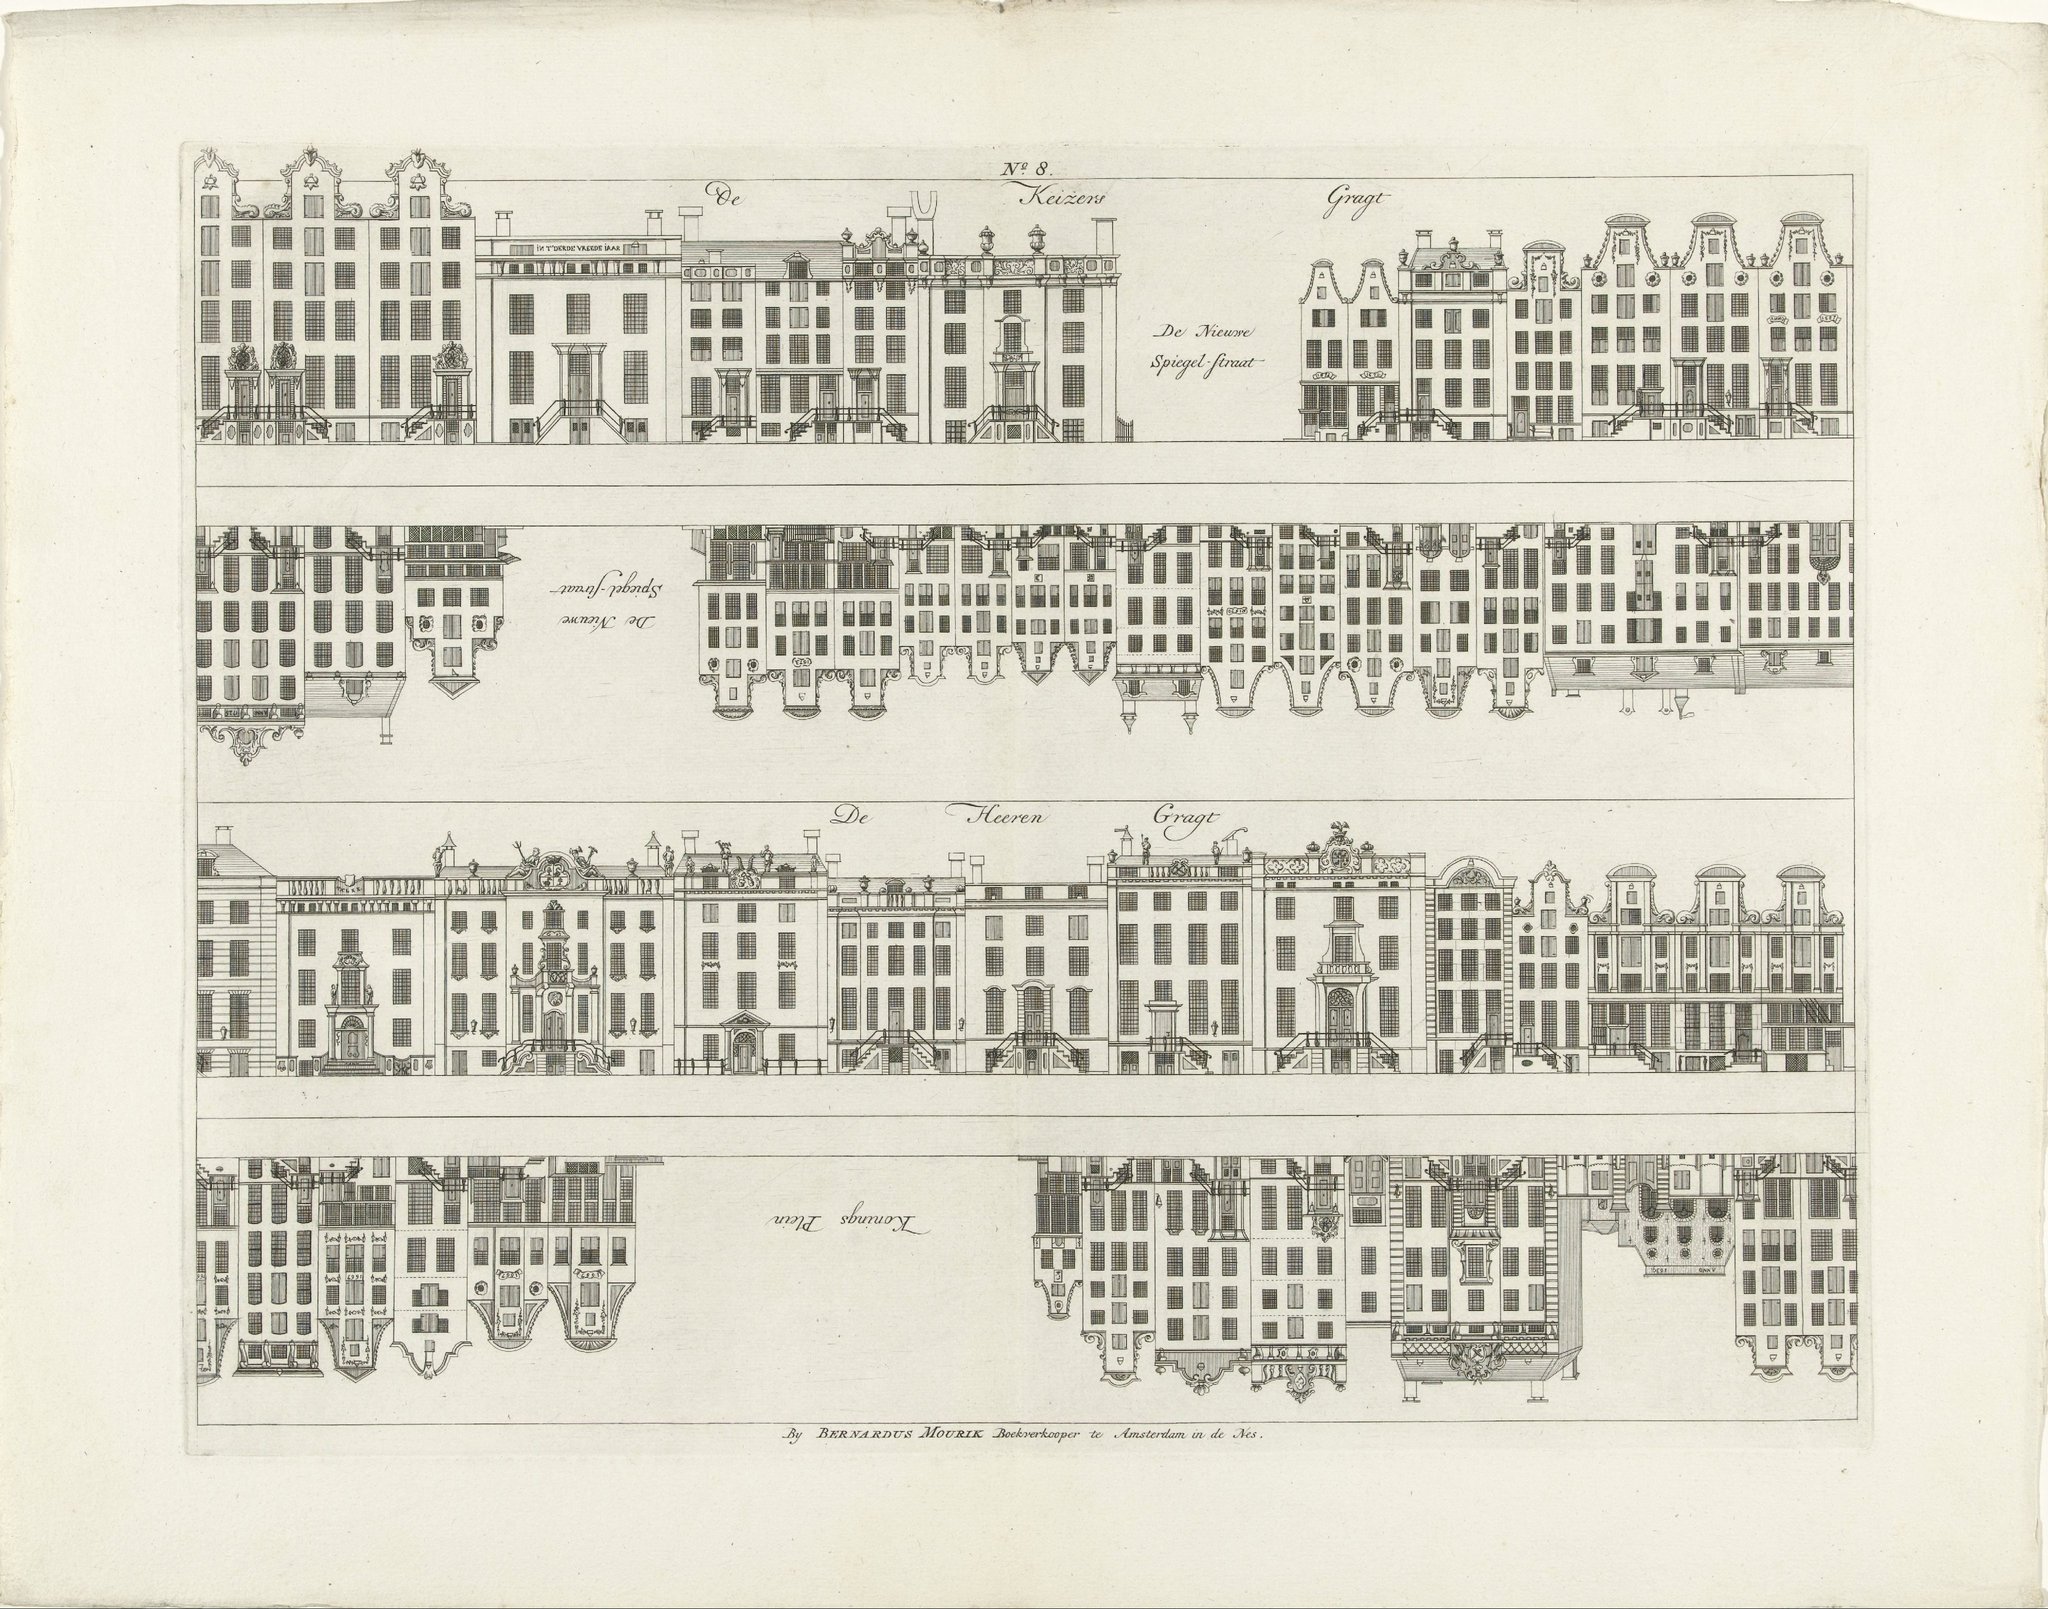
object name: print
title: Verzameling van alle De Huizen en Gebouwen langs de Keizers en Heeren-Grachten der Stad Amsterdam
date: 1768-1771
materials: paper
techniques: etching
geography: amsterdam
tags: front façade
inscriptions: collector's mark: Lugt 2228, collector's mark: Lugt 2233